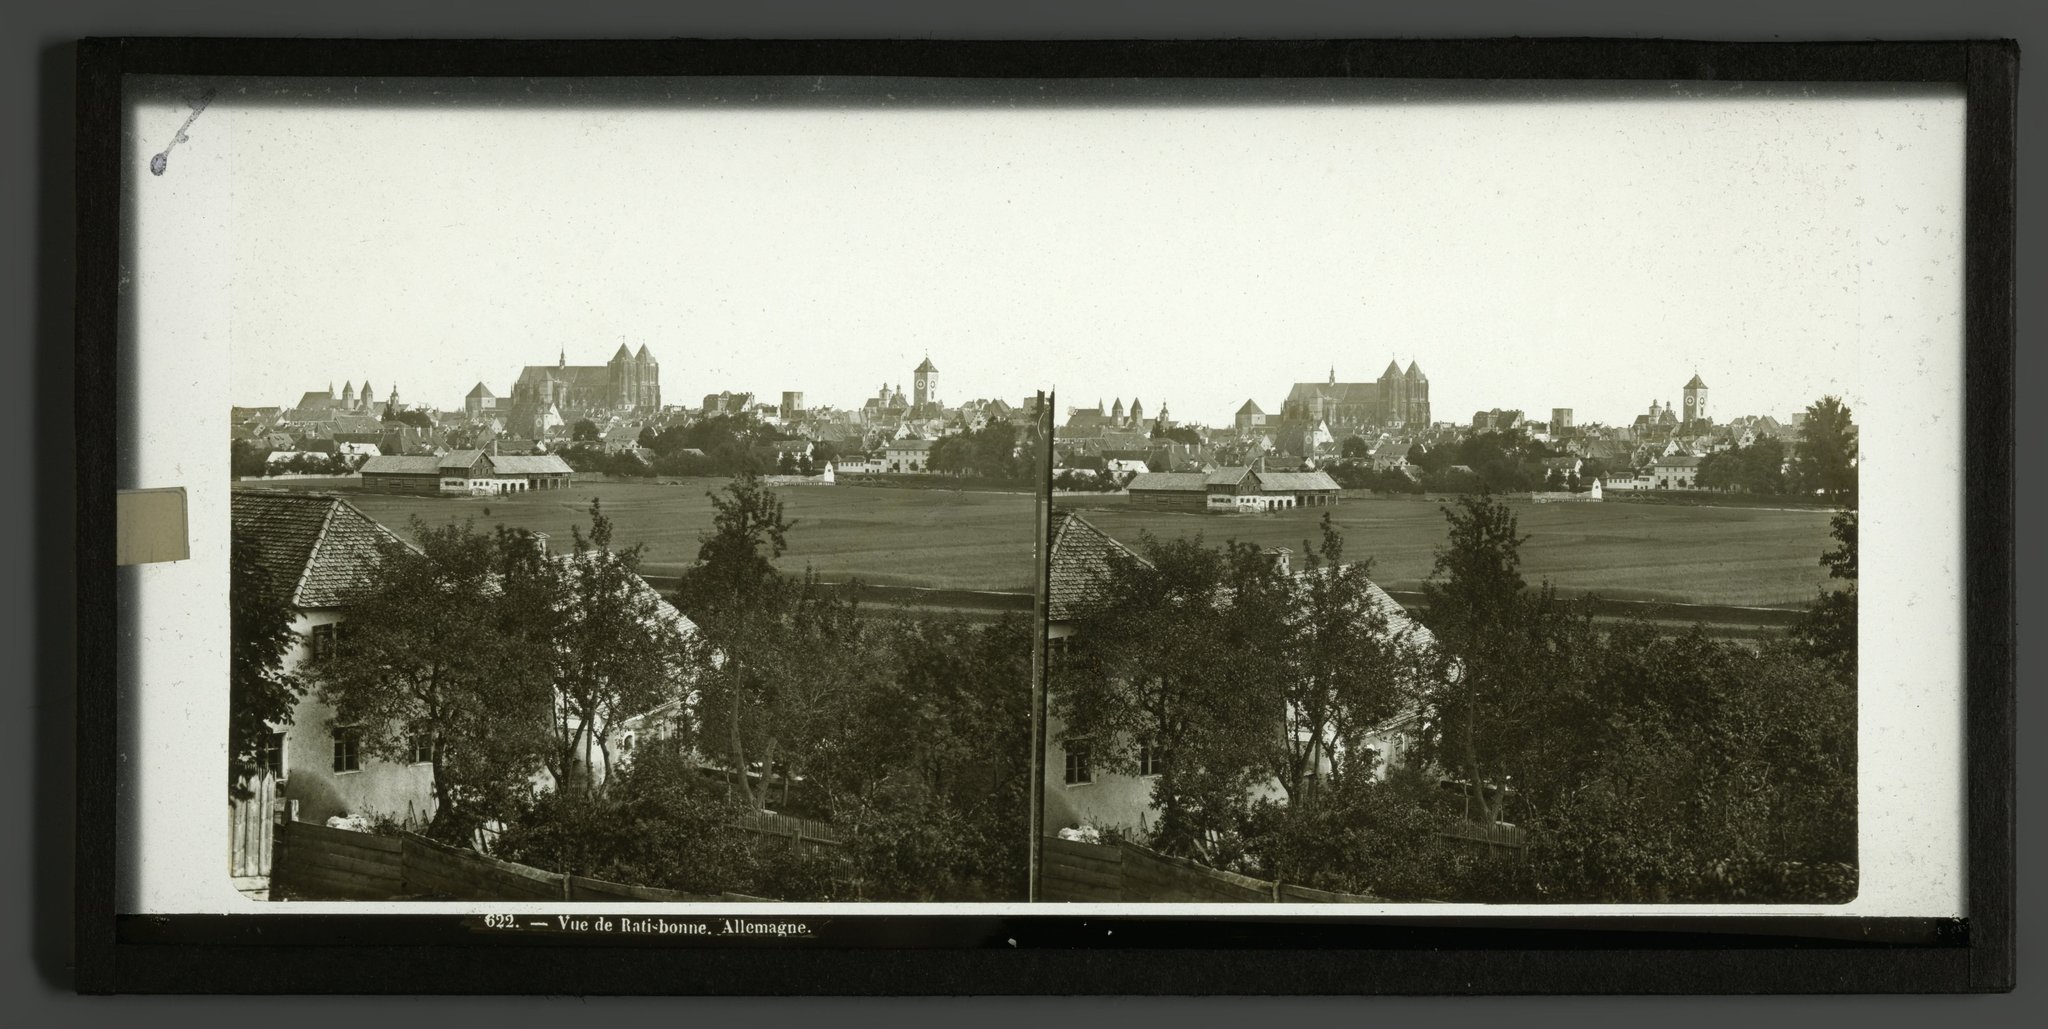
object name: photograph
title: Gezicht op Regensburg, in de verte de Dom van Regensburg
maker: ferrier père-fils et soulier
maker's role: publisher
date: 1860-1865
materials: glass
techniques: slide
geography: regensburg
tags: city-view in general; 'veduta'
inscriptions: number: ‘622.’